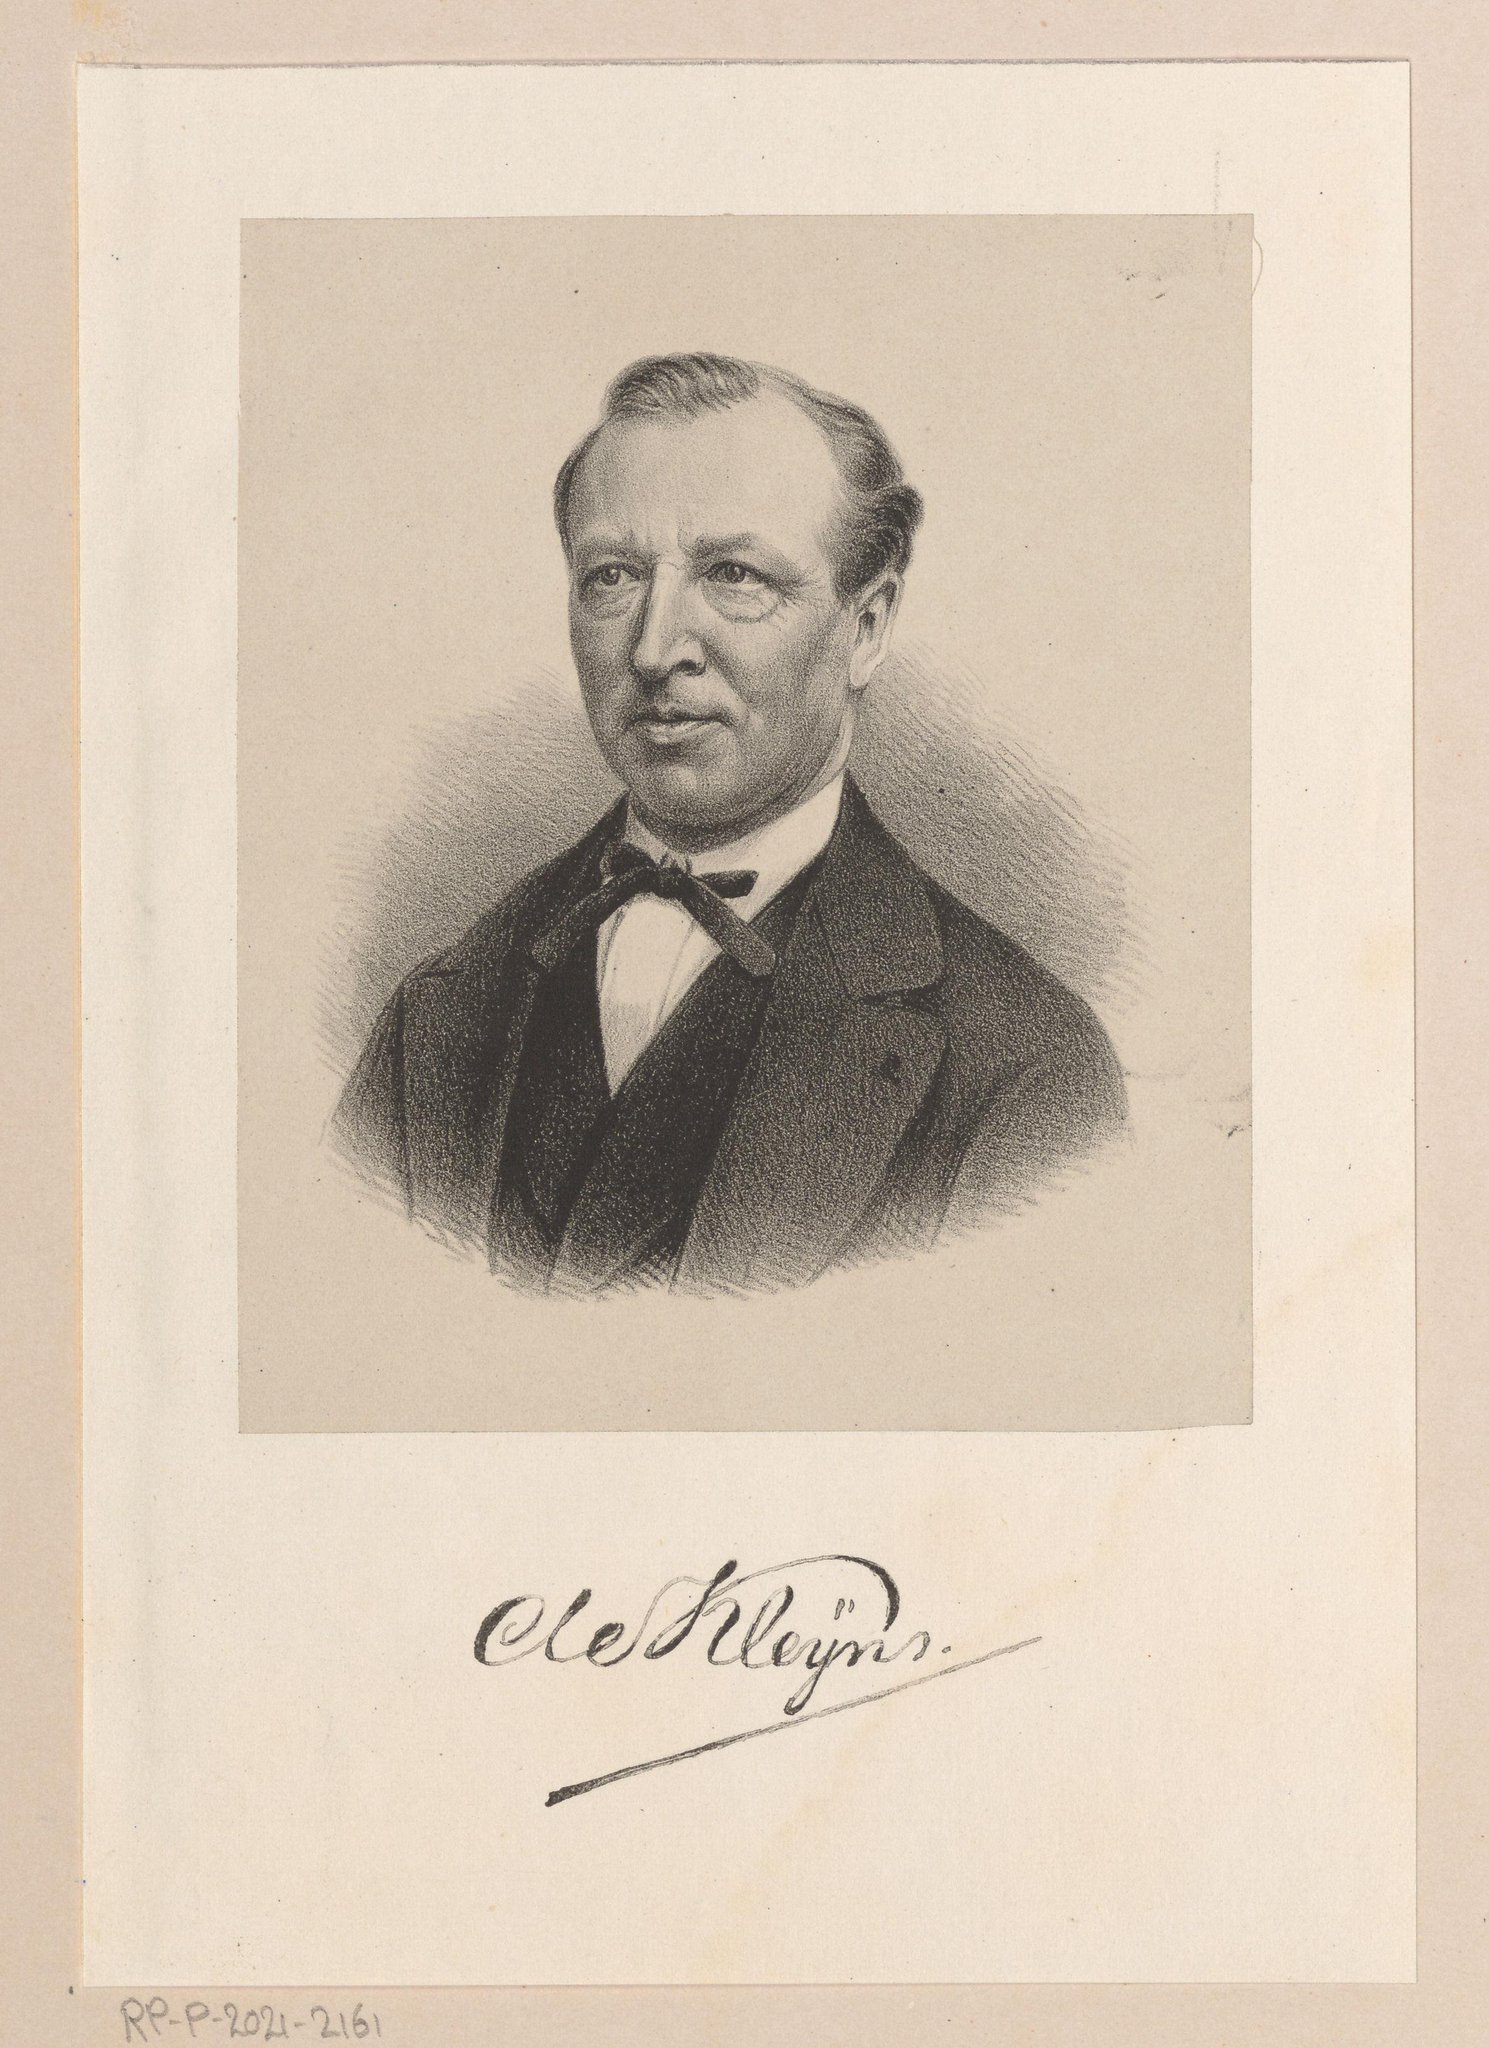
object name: print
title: Portret van Zacharias Henricus Kleijn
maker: Anonymous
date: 1853-1899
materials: paper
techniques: lithograph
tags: historical persons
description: Onder het portret een facsimile van de handtekening van de geportretteerde.